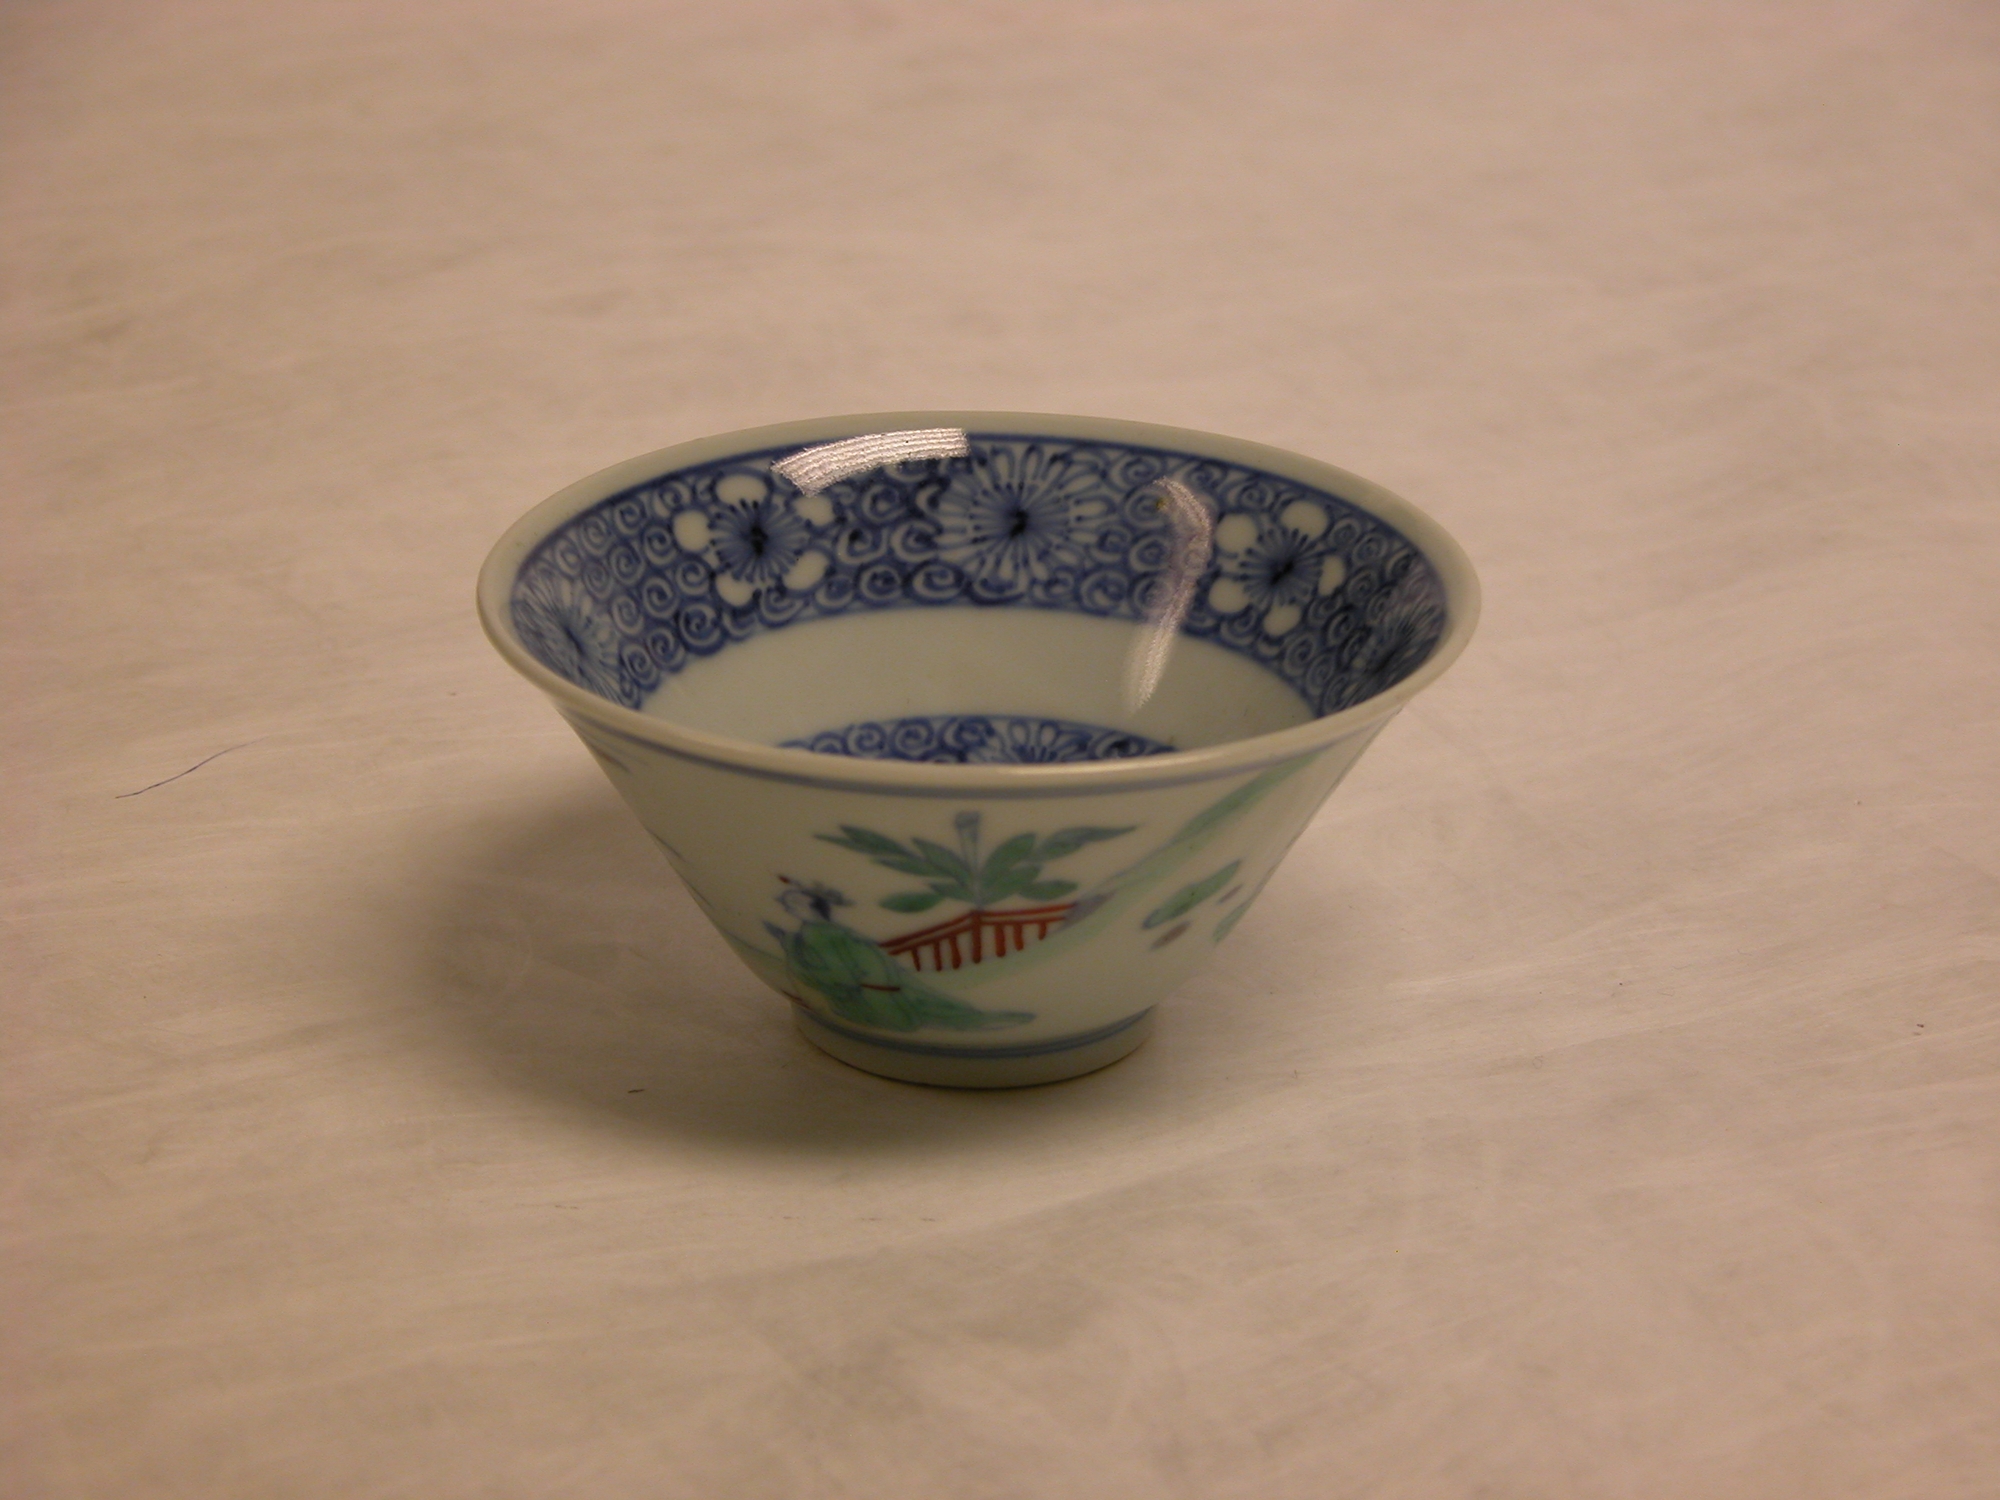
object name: bowl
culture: chinese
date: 1640-1911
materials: enamel, porcelain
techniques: overglaze, painting, polychrome, underglaze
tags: human figures,flowers